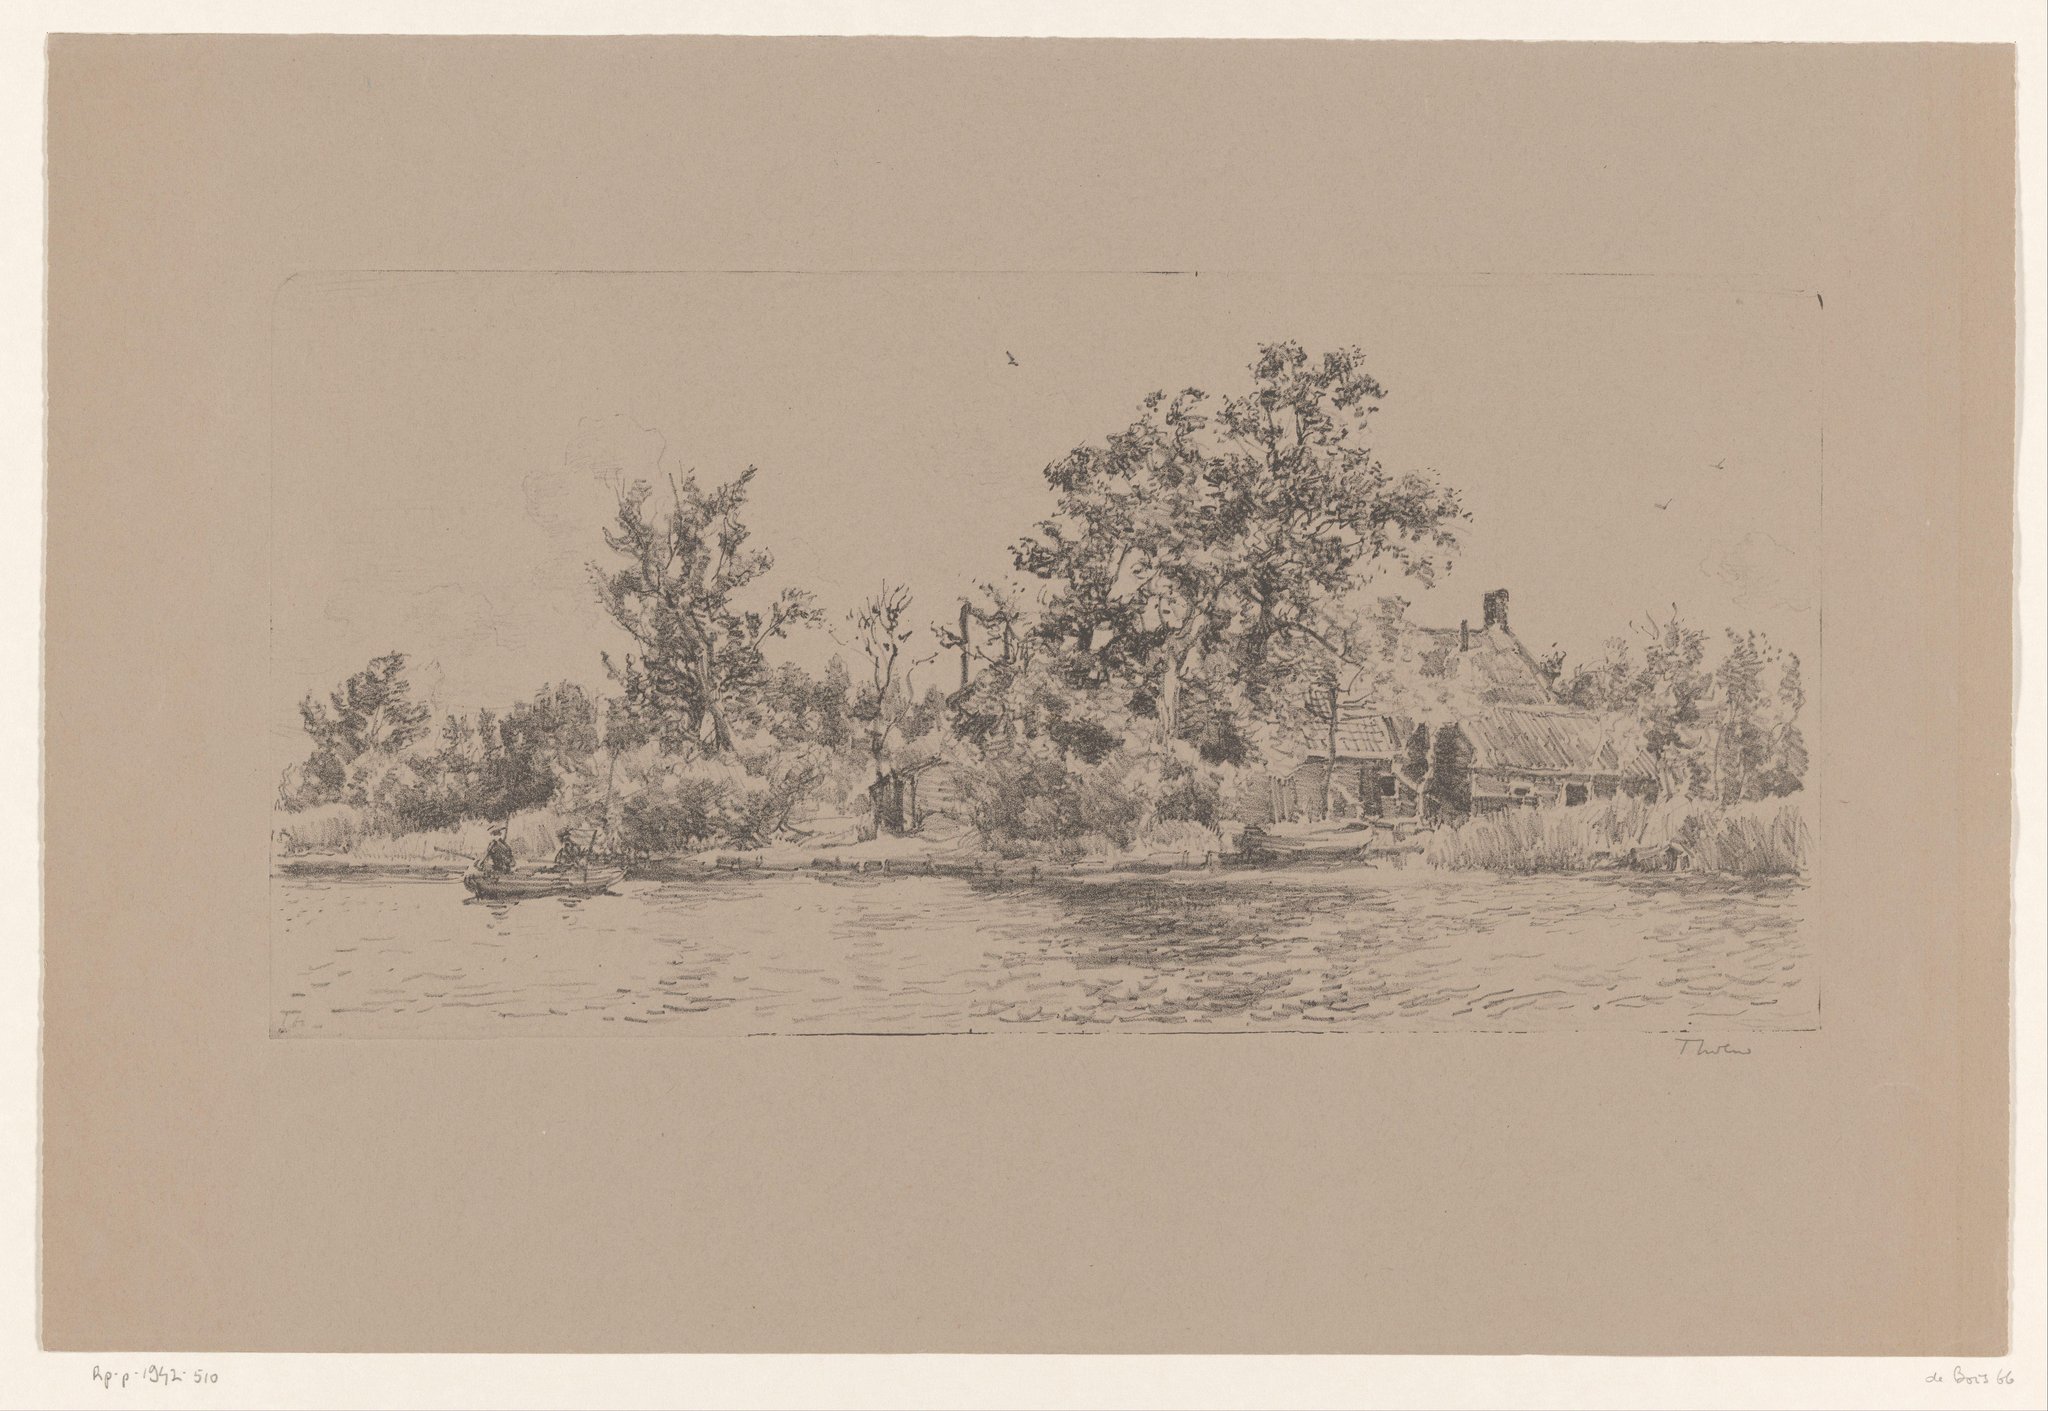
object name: print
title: Landschap met boerderij en hengelaars in een boot op het water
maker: willem bastiaan tholen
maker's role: draughtsman, painter, print maker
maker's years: 1860-1931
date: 1905-1920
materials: paper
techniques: lithograph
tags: rowing-boat, canoe, etc., farm or solitary house in landscape, fisherman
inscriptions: collector's mark: Lugt 2228